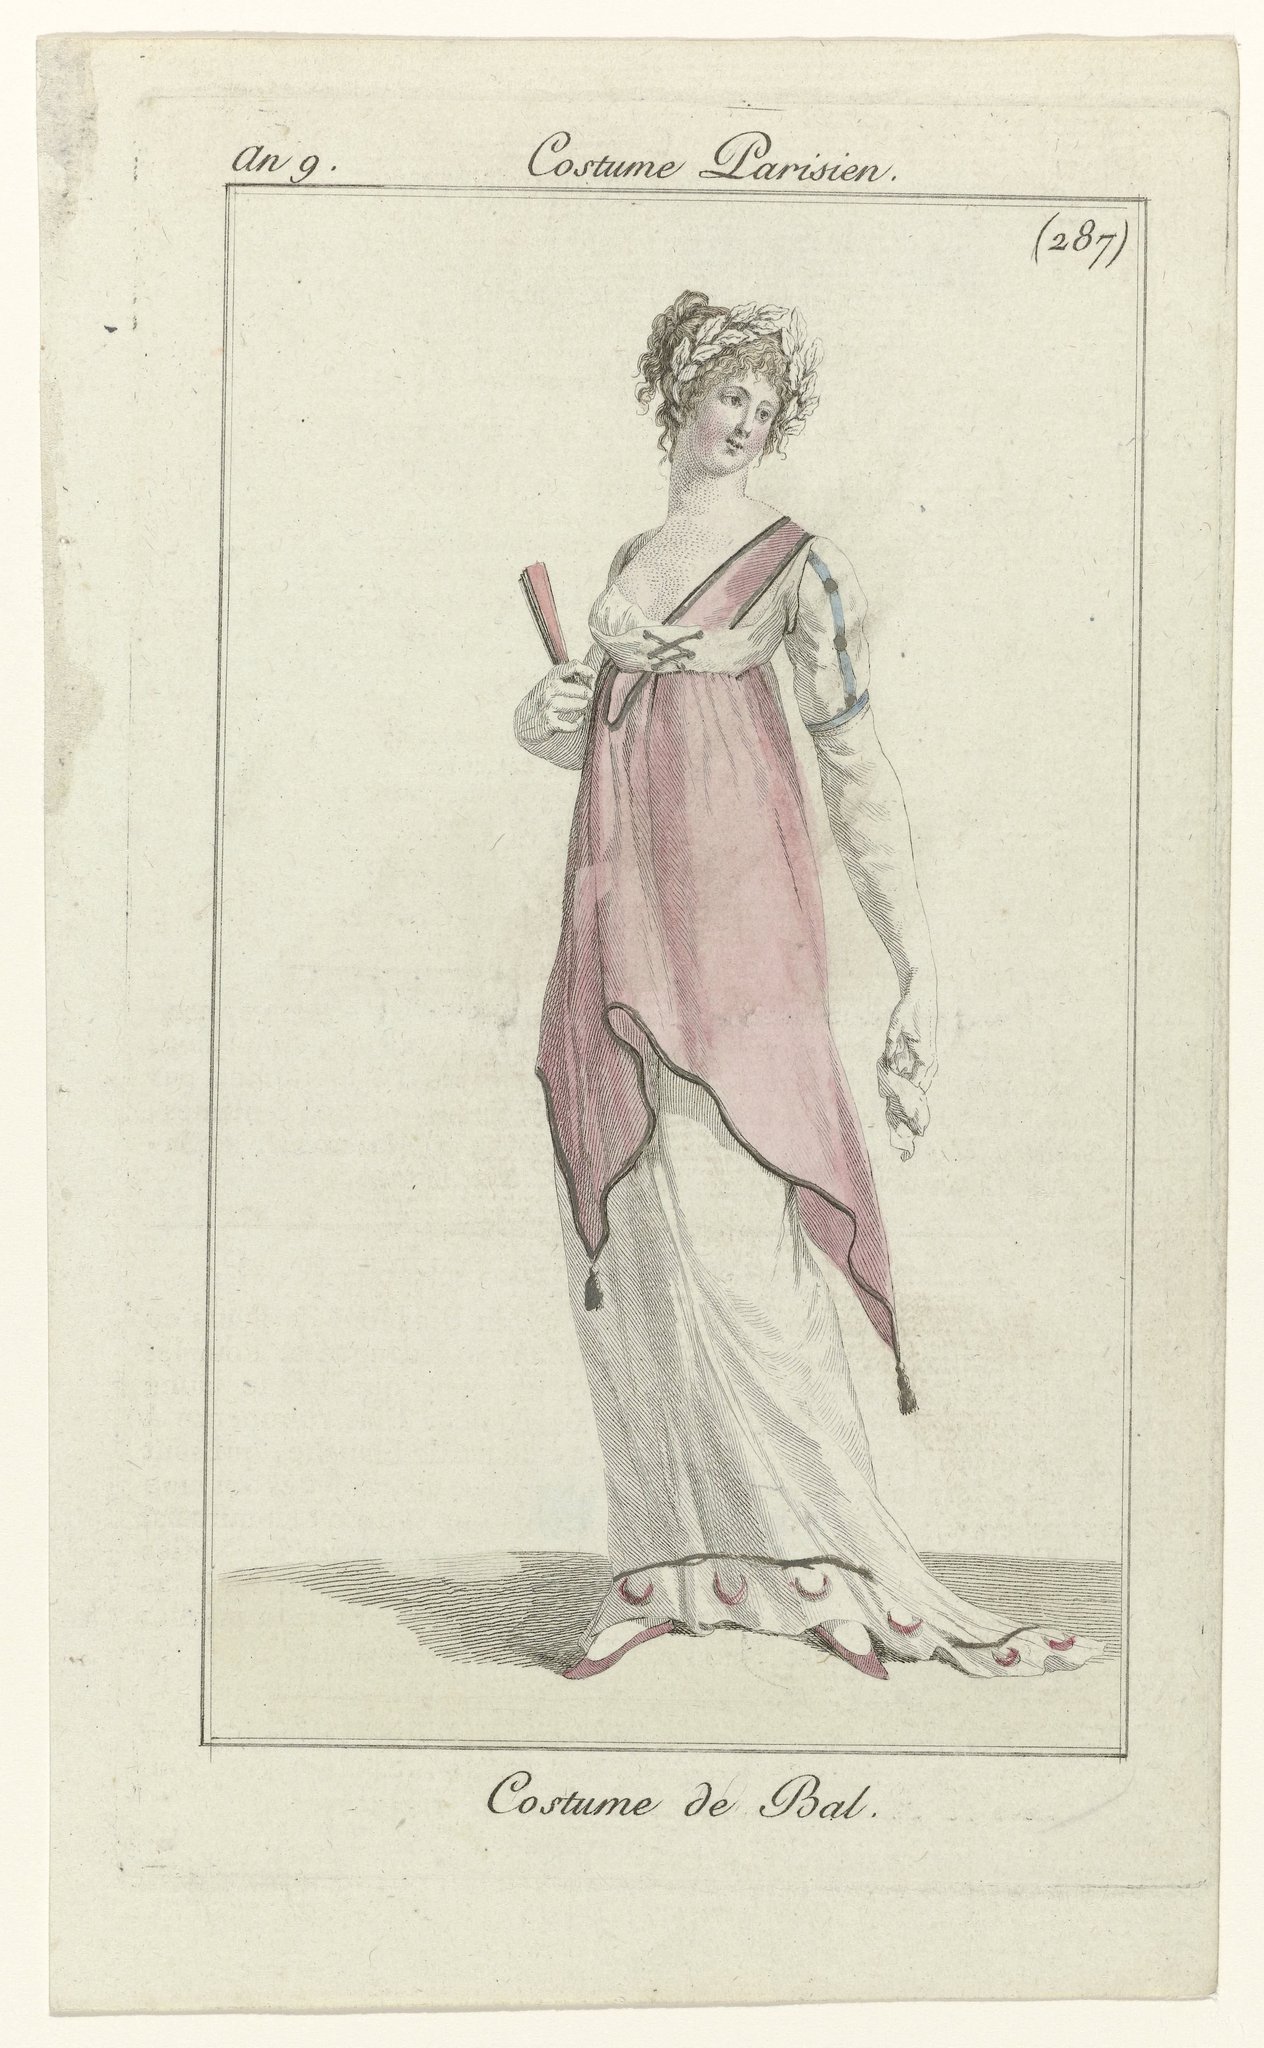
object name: fashion print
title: Journal des Dames et des Modes, Costume Parisien, 16 mars 1801, An 9 (287) : Costume de Bal.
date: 1801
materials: paper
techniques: engraving, hand coloring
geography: paris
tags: handkerchief (+ women's clothes), gloves, mittens (long gloves) (+ women's clothes), dress, gown: ball gown (+ women's clothes), clothing for the upper part of the body (tunic) (+ women's clothes), head-gear (+ women's clothes), fashion plates, shoes, sandals (+ women's clothes), fan (+ women's clothes)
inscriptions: caption: ‘Costume de Bal’, title: ‘Costume Parisien.’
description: Balkostuum: tuniek uitlopend in punten met kwasten op een japon met sleep, afgezet met een patroon van puntige halve cirkels. Accessoires: lauwerkrans op het hoofd, lange handschoenen, waaier, zakdoek, platte schoenen. De prent maakt deel uit van het modetijdschrift Journal des Dames et des Modes, uitgegeven door Pierre de la Mésangère, Parijs, 1797-1839.